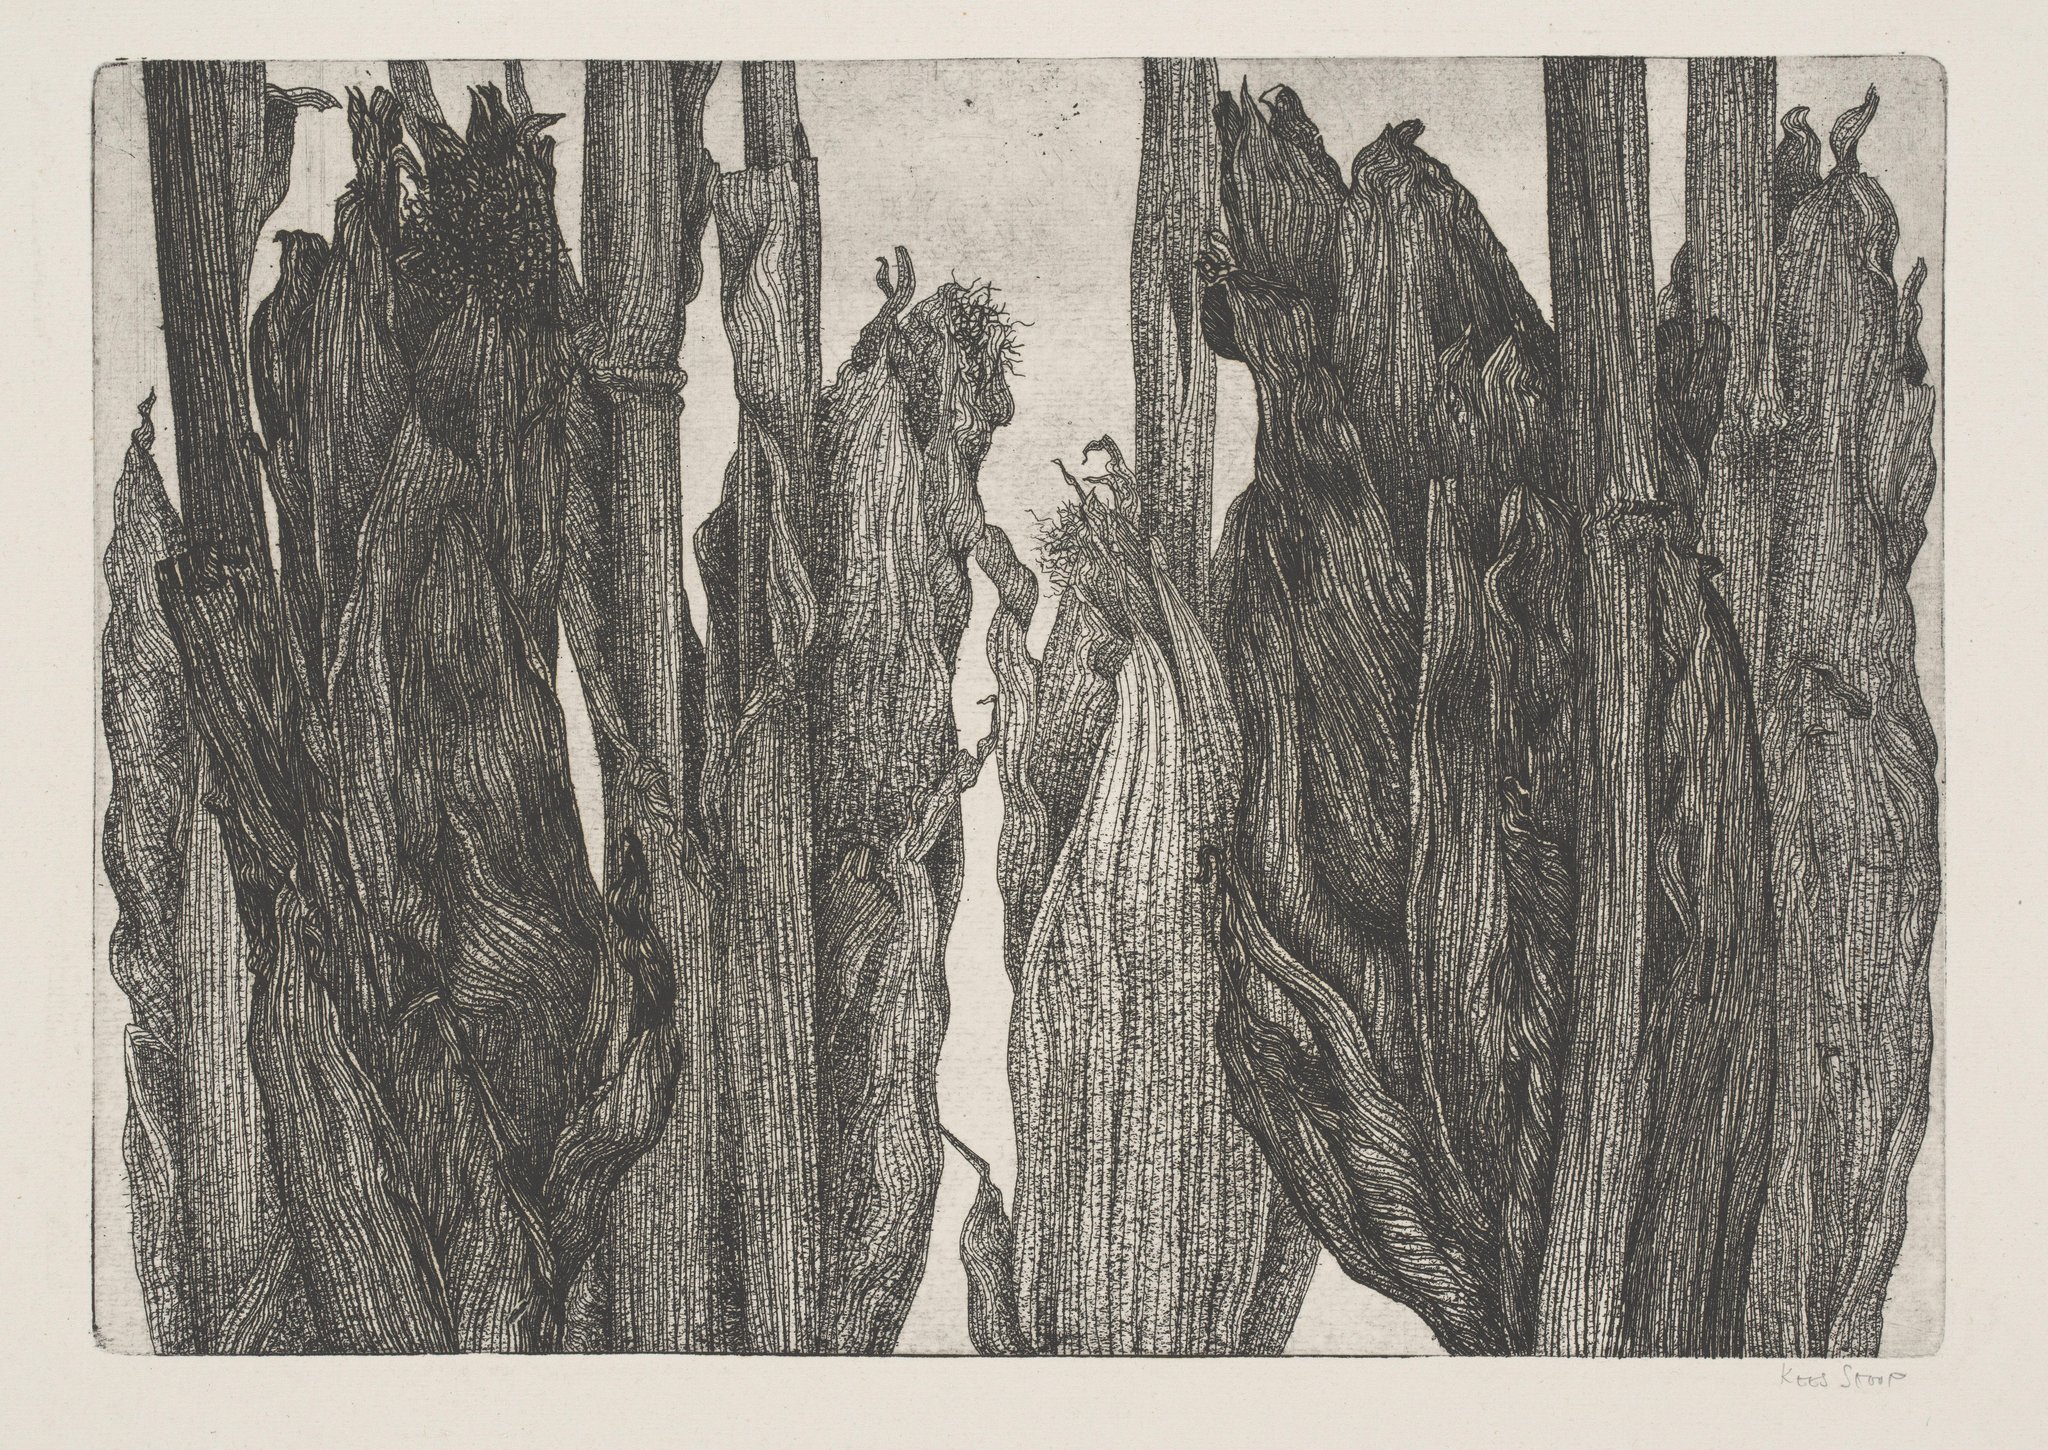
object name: print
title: Maïskolven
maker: kees stoop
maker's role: draughtsman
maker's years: 1929-2019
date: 1944-1990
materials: paper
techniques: etching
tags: ear of corn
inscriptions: signature: ‘KEES STOOP’